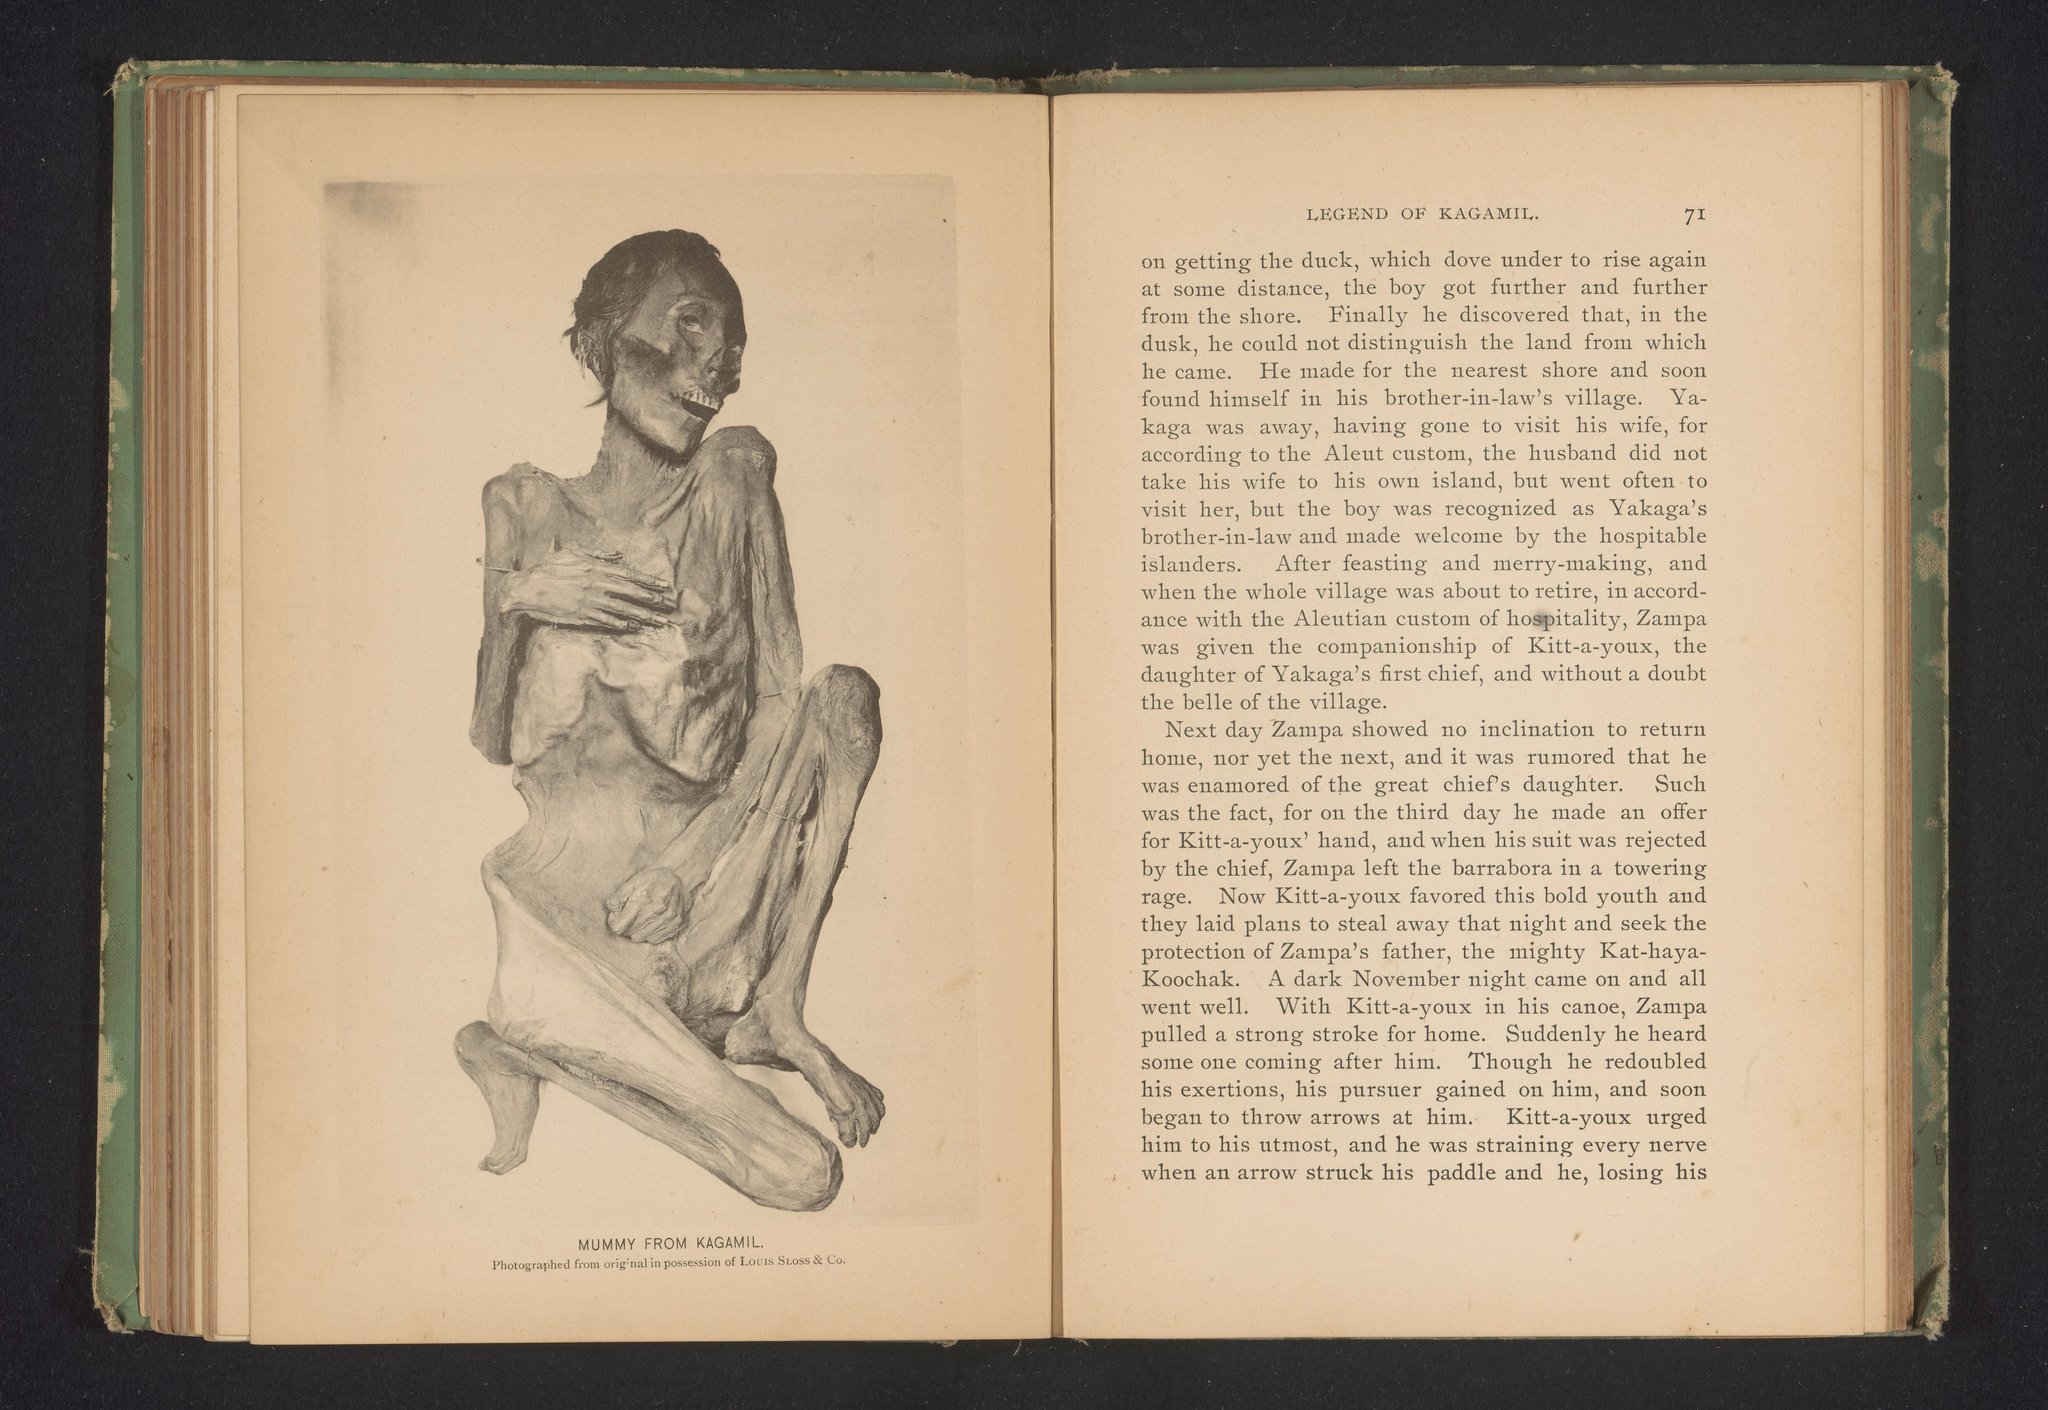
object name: photomechanical print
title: Mummy from Kagamil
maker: Anonymous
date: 1885-1890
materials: paper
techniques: photograph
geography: new york city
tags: mummy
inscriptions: inscription: ‘Photographed from original in possession of Louis Sloss & Co.’